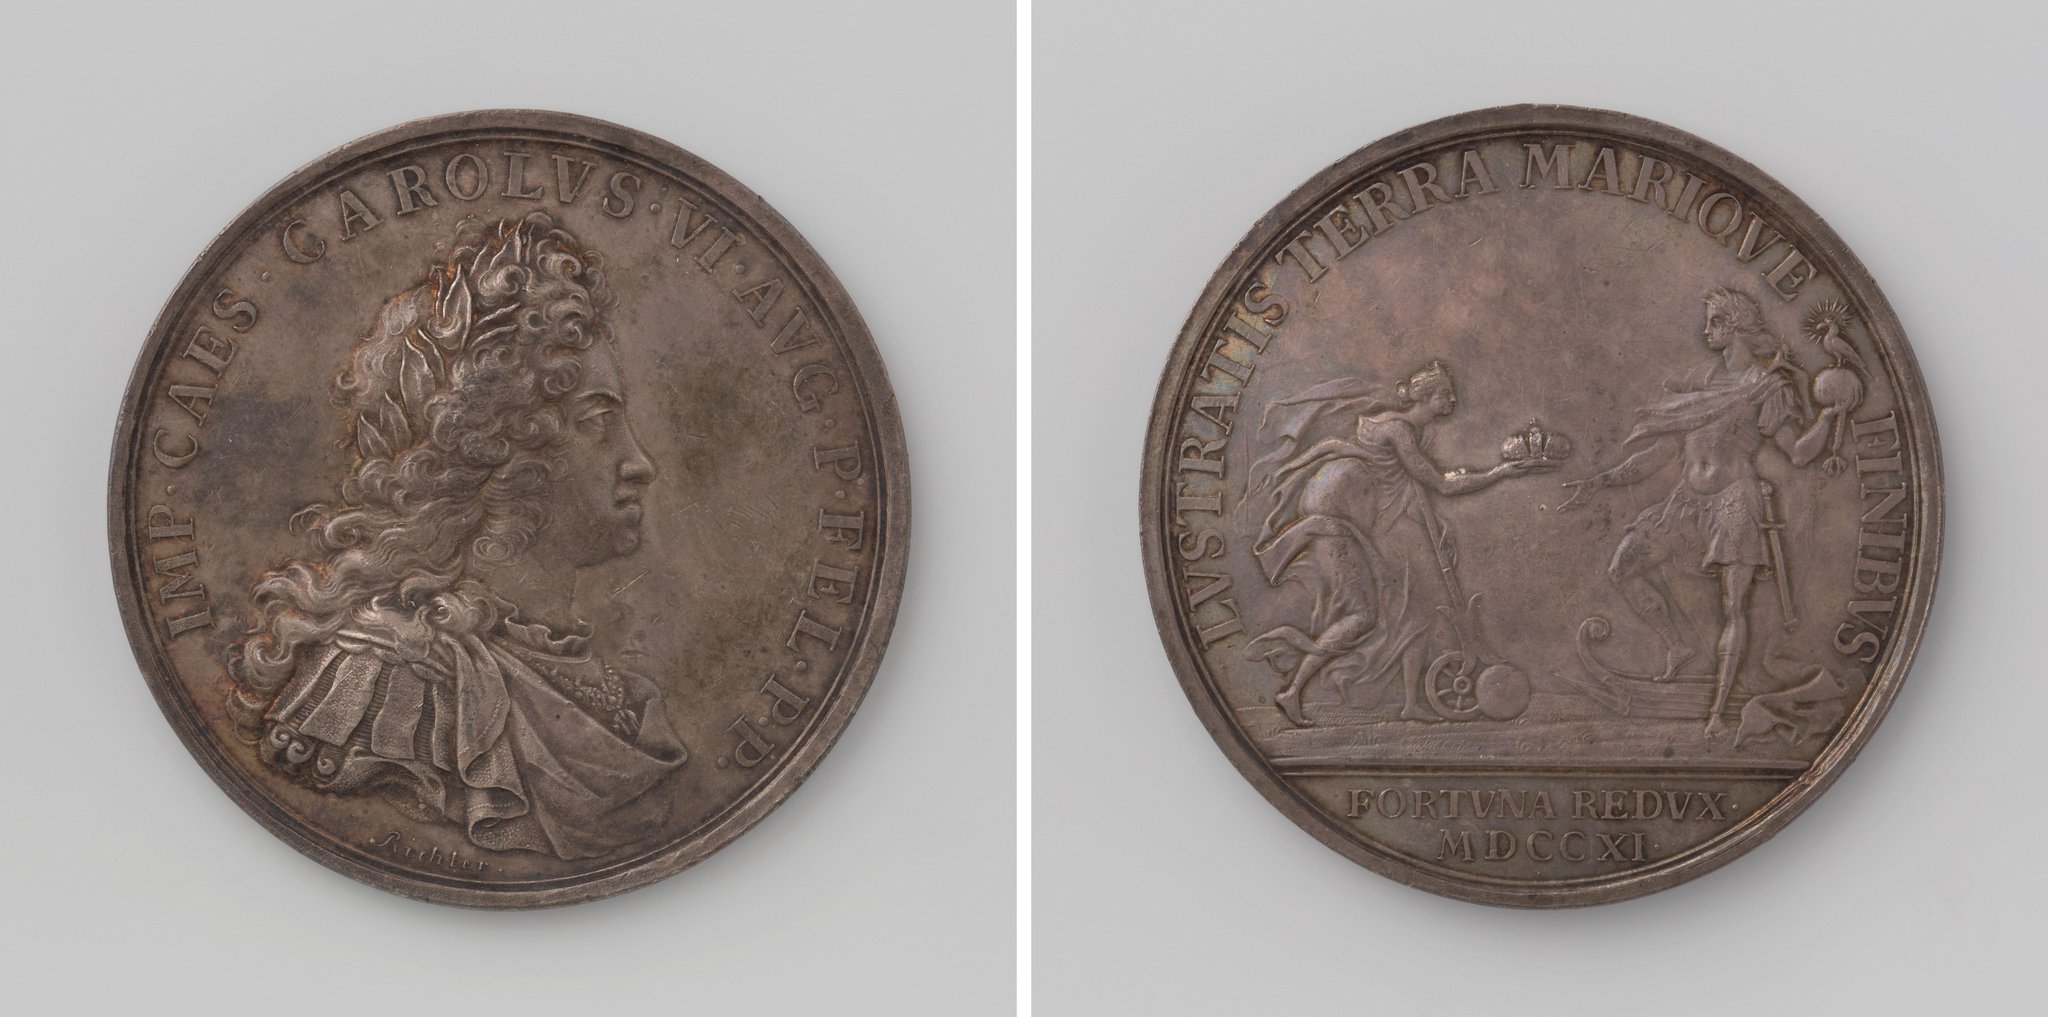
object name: history medal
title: Karel VI tot Duits keizer gekroond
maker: bengt richter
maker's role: medailleur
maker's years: 1670-1735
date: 1711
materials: silver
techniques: striking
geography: berlin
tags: charles vi (holy roman emperor)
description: Zilveren penning. Voorzijde: borststuk man met lauwerkrans binnen omschrift. Keerzijde: man met in zijn hand bol met vogel erop, staande met een voet op schip ontvangt van vrouw met scheepsroer kroon binnen omschrift; afsnede: opschrift